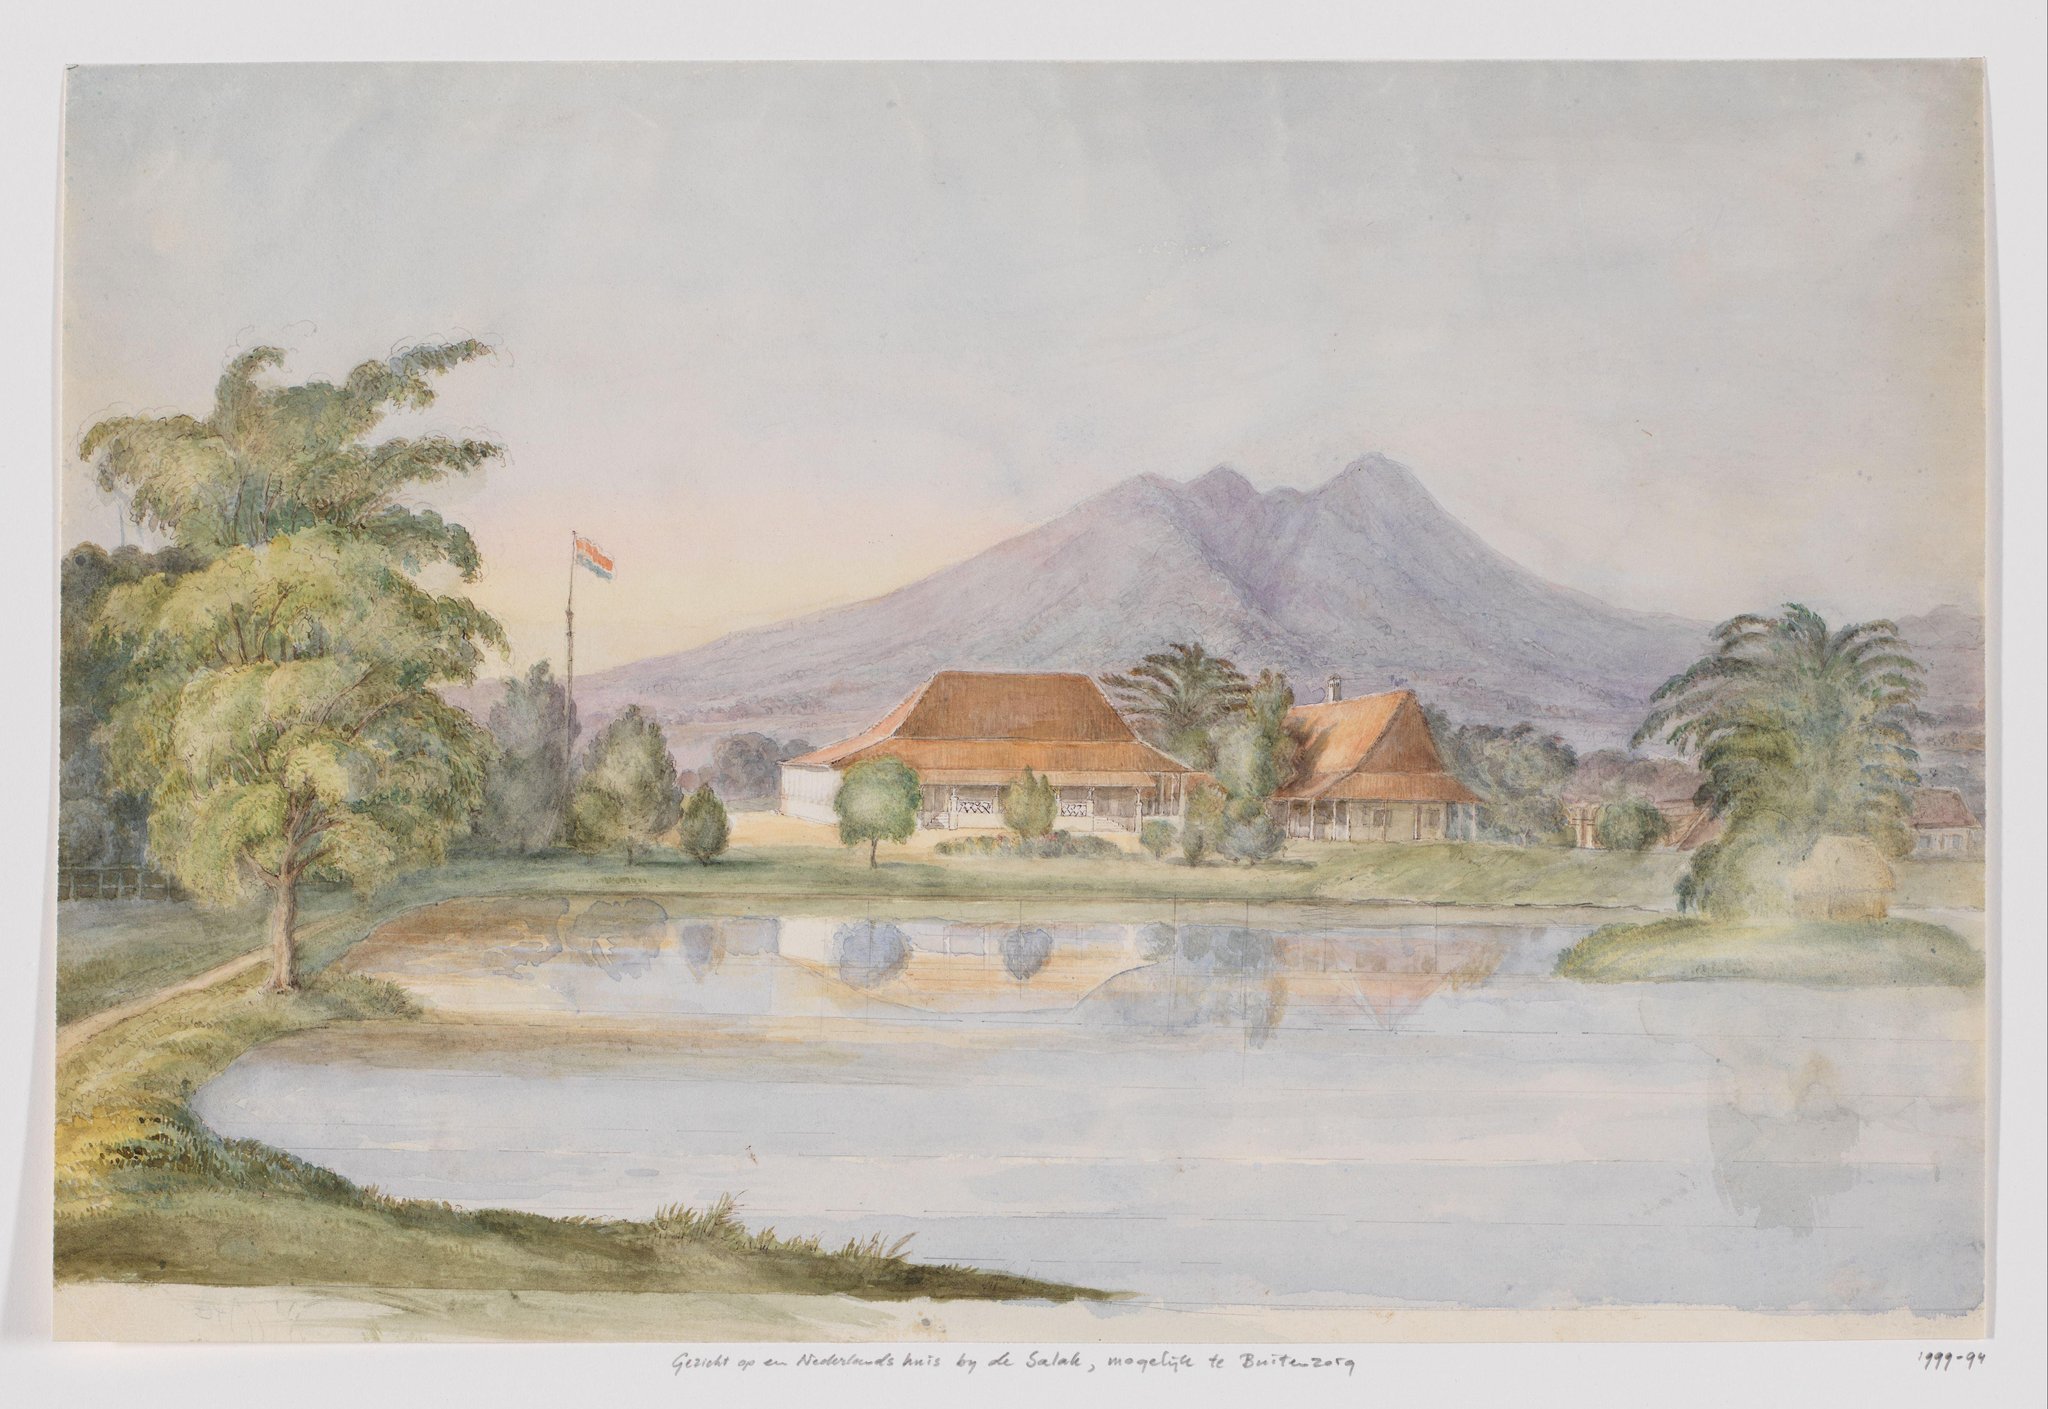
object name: drawing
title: Gezicht op een huis met een Nederlandse vlag en vijver tegen een berg, West-Java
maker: adrianus johannes bik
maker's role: draughtsman, print maker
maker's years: 1790-1872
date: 1816-1846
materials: ink, paper, pencil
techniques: brush, pen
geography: west java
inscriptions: inscription: ‘Buitenzorg?’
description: De berg heeft het profiel van de Salak; dit zou dus in de buurt van Buitenzorg getekend kunnen zijn [M.-O.S].. artikel over deze collectie in Bulletin van het Rijksmuseum 49 [2001], nr. 4, pp 342 e.v.